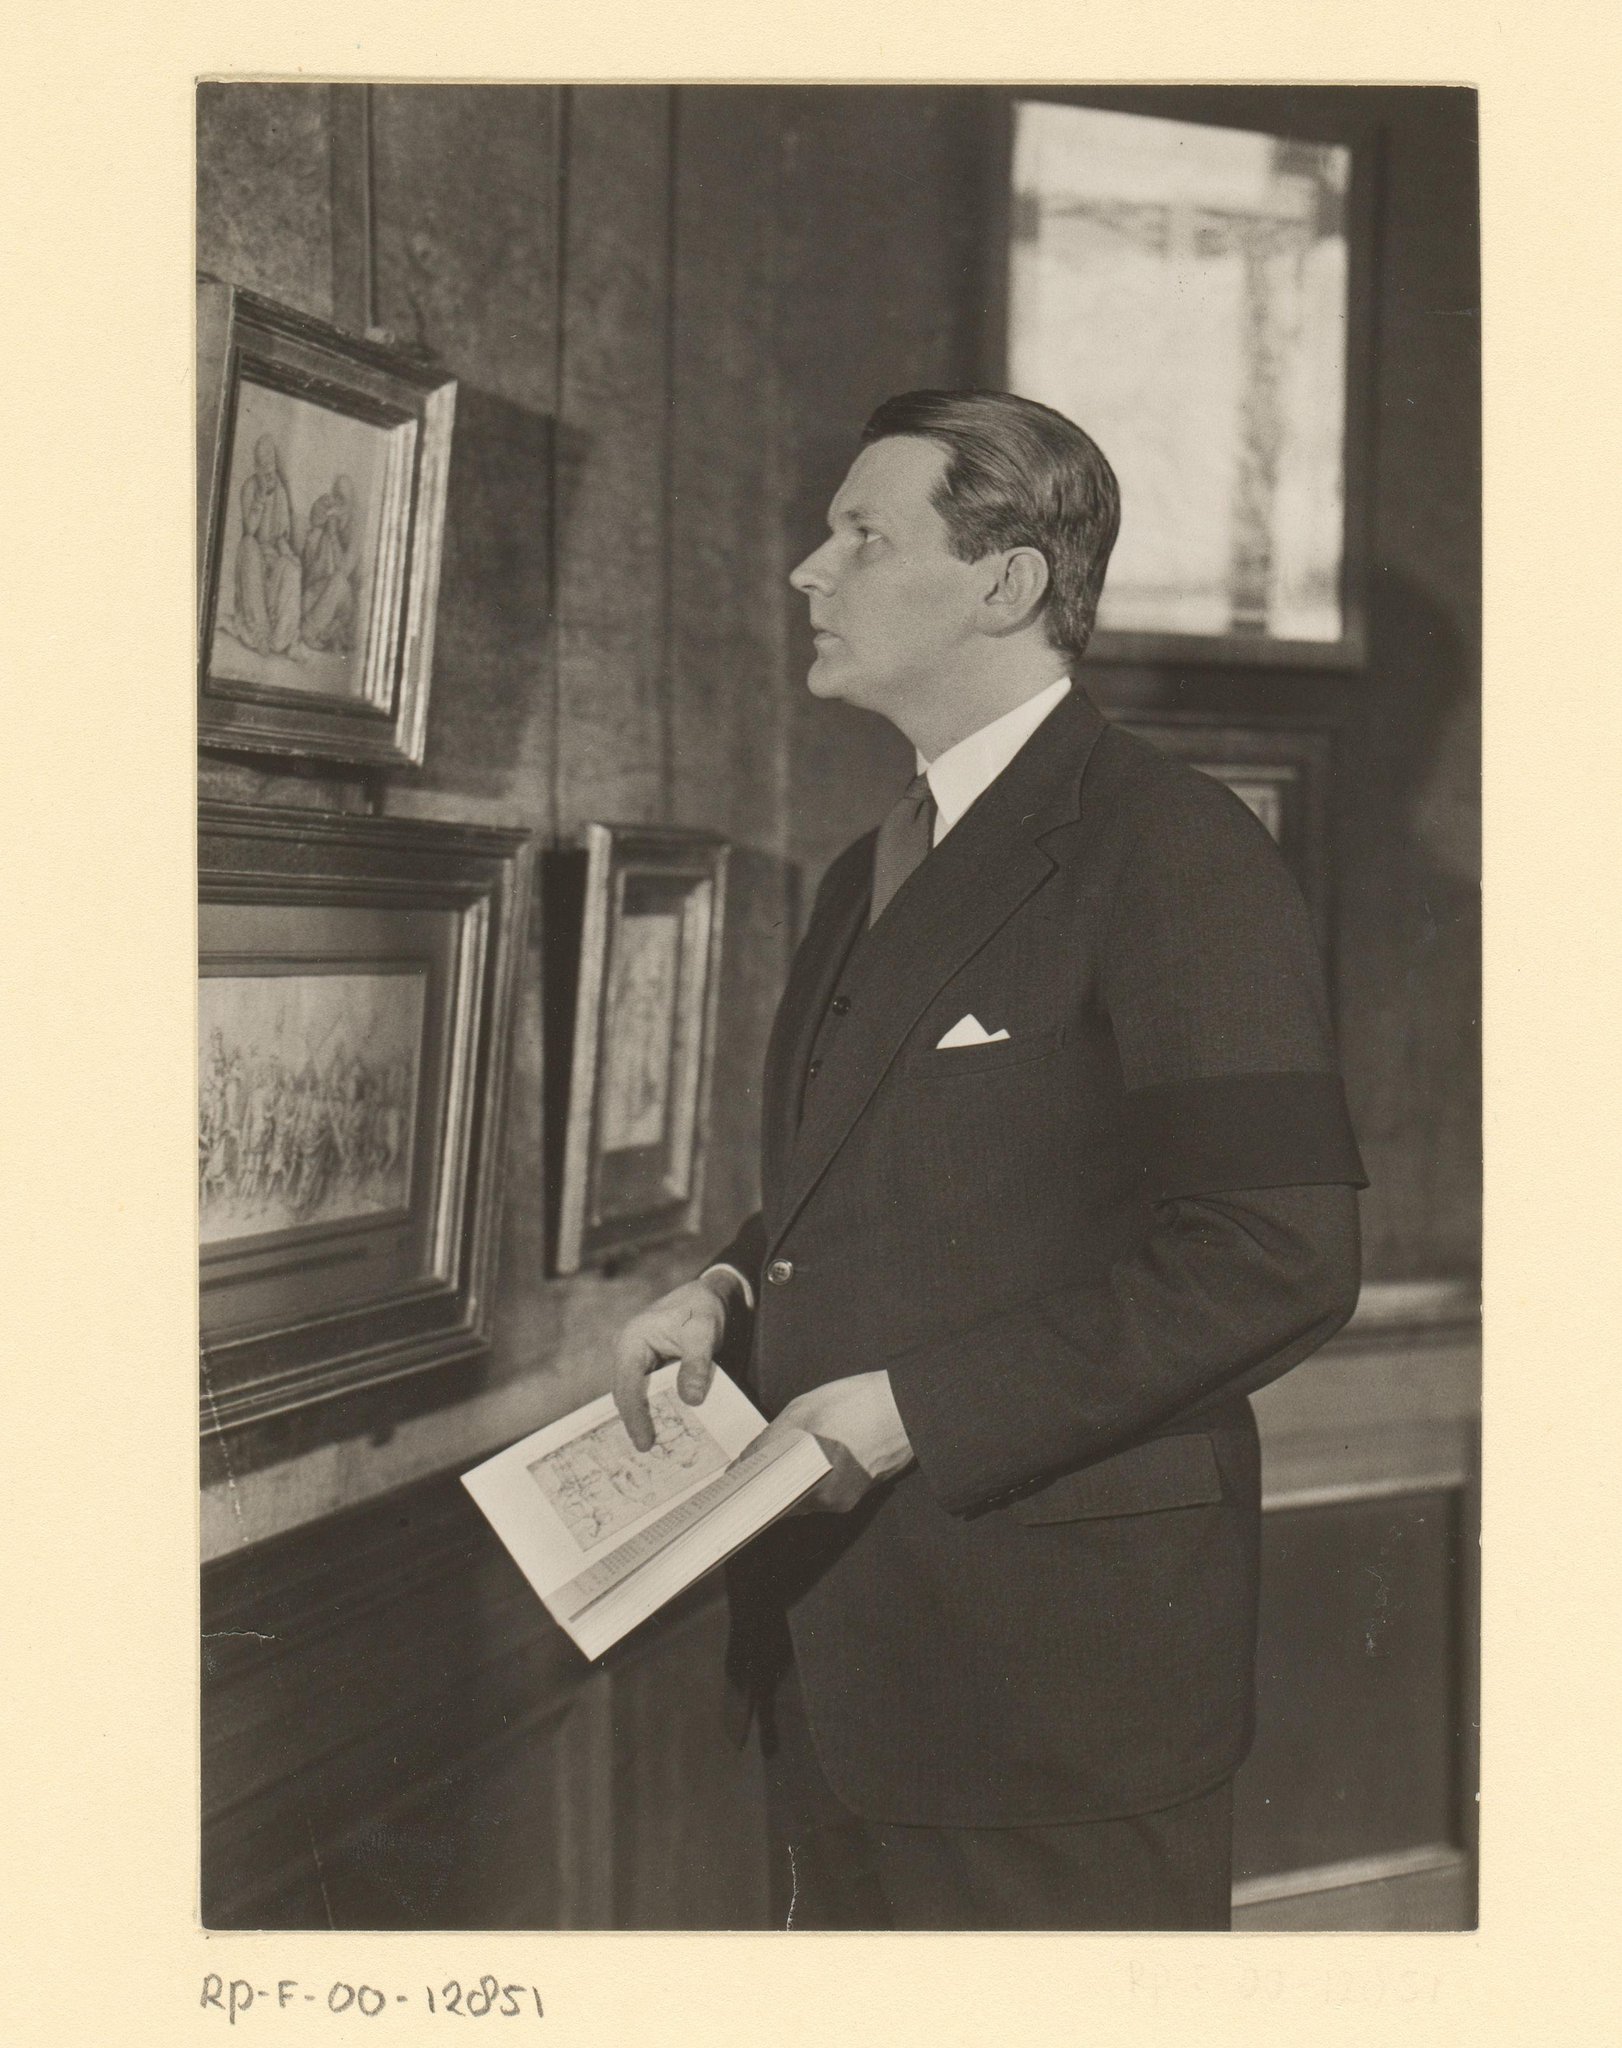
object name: photograph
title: Portret van Dirk Hannema kijkend naar schilderijen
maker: Anonymous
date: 1921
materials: paper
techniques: gelatin silver print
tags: dirk hannema, historical persons, permanent exhibition, museum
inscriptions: collector's mark: ‘RIJKSMUSEUM/ AMSTERDAM’